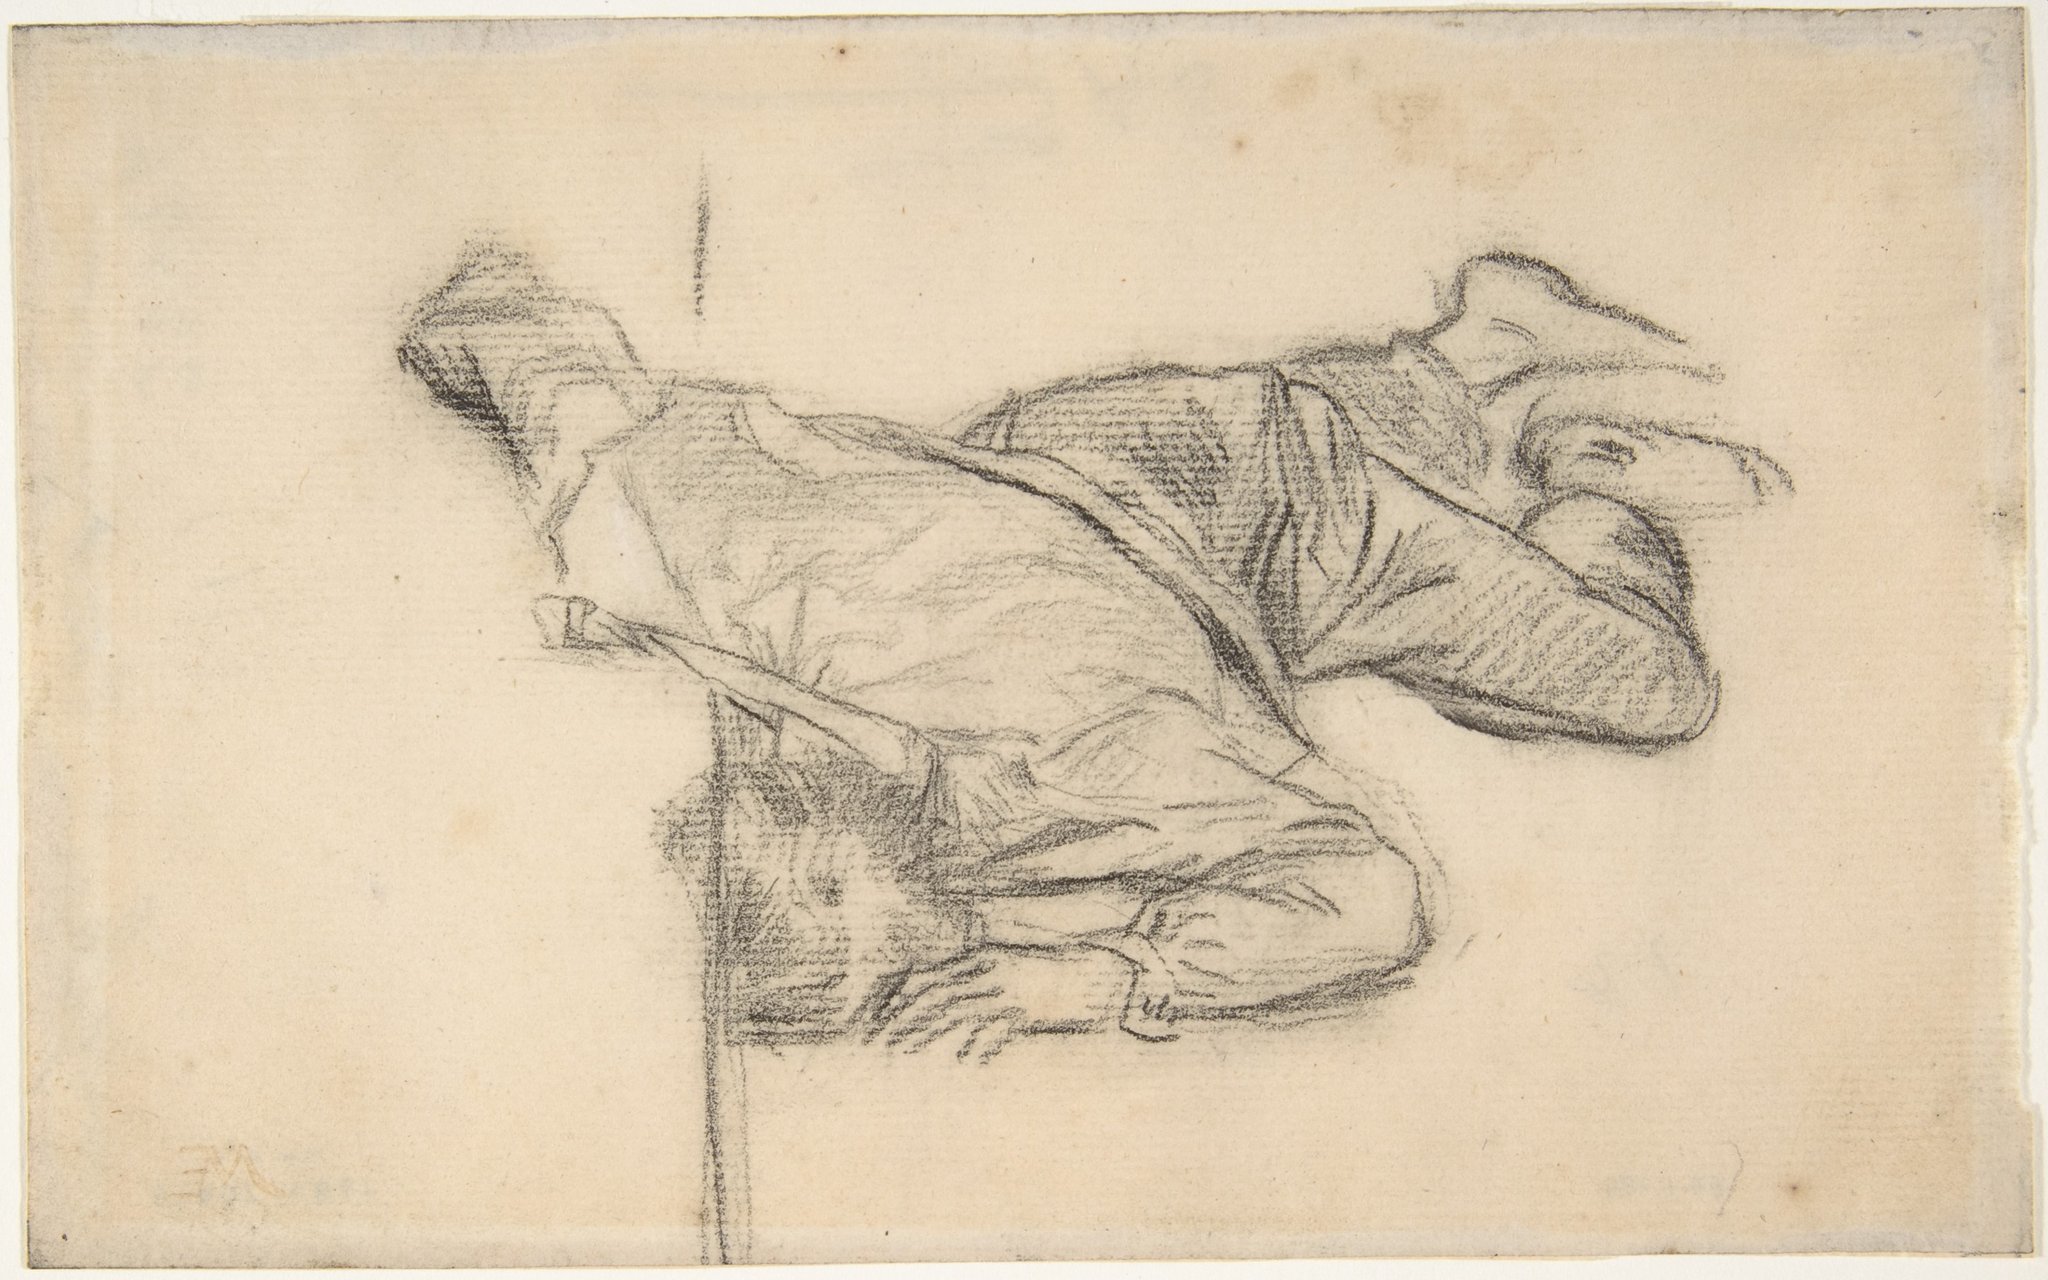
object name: drawing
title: Dead Man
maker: ernest meissonier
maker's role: artist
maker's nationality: french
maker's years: 1815-1891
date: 1830-1891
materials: chalk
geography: france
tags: men,death